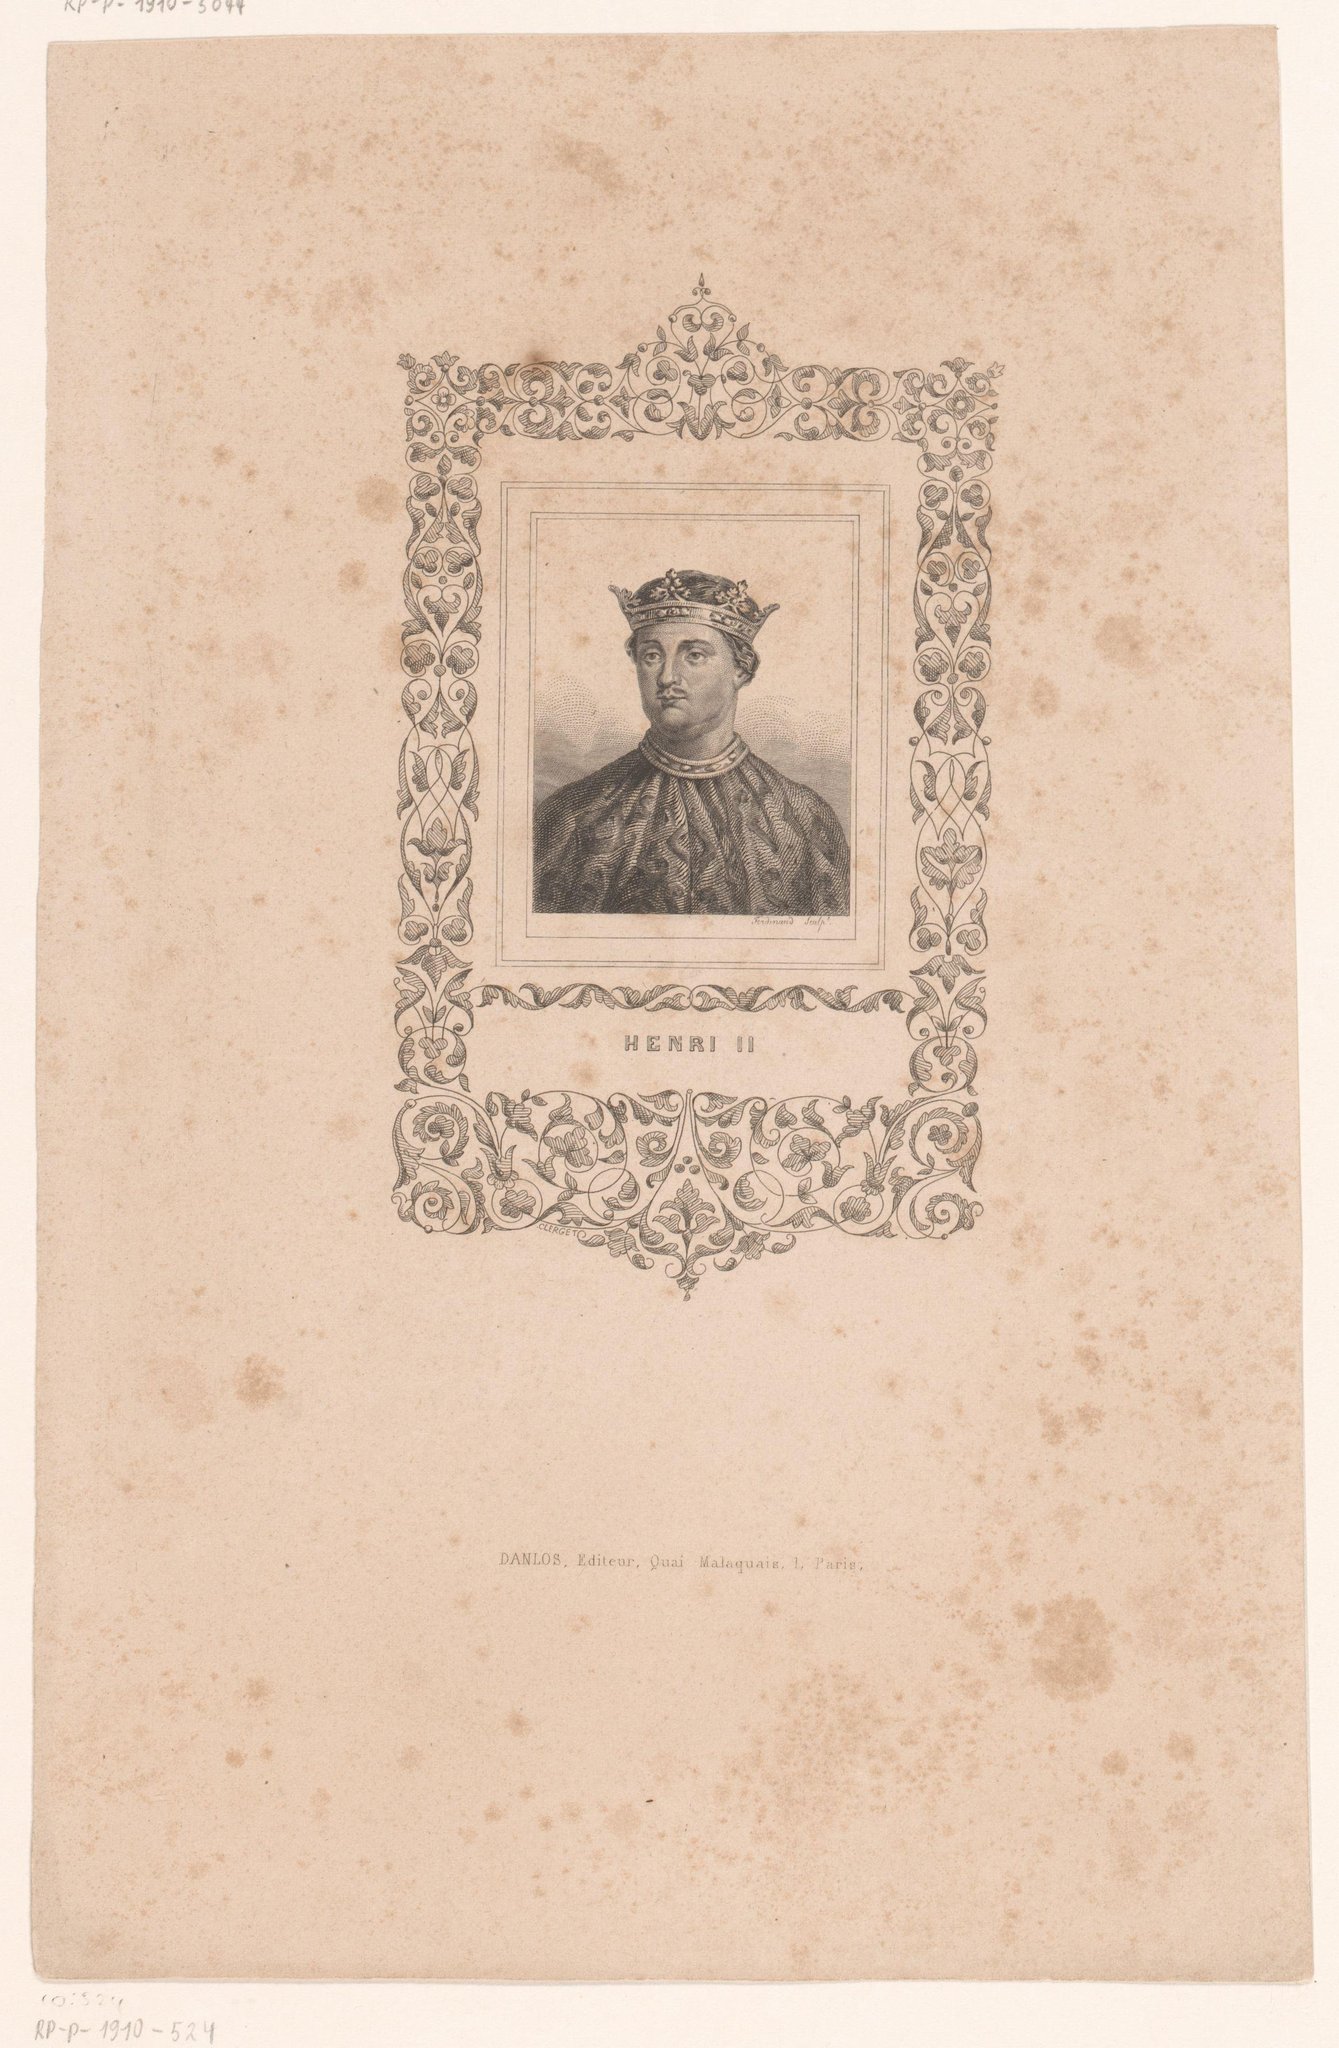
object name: print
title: Portretten van vooraanstaande personen onder het bewind van Napoleon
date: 1828-1899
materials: paper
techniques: etching, engraving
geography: paris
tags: paris, historical persons, ornament ~ cartouche, ruler, sovereign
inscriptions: collector's mark: Lugt 2228